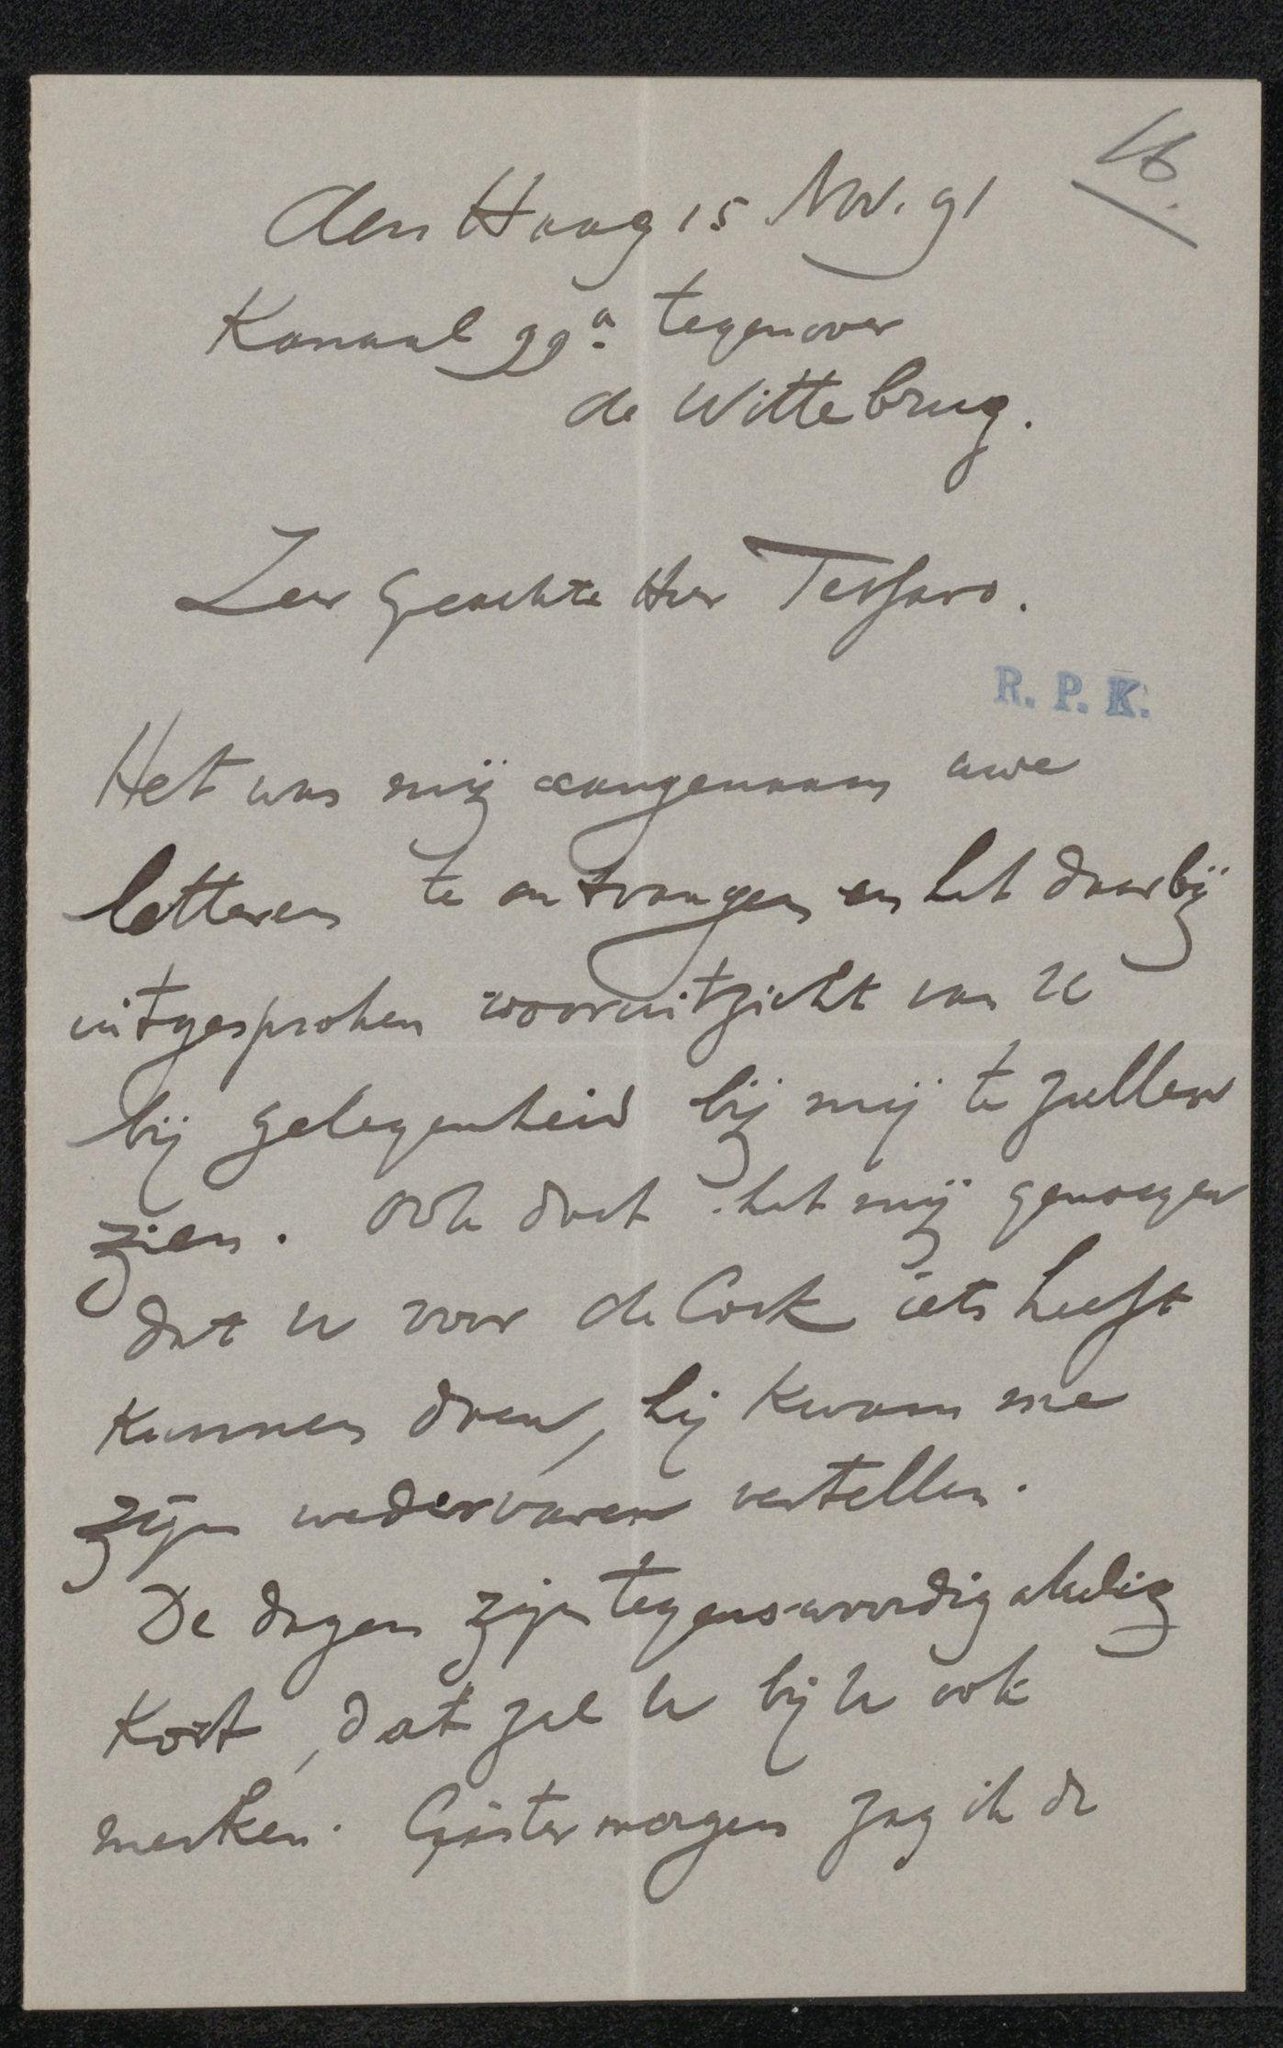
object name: letter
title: Brief aan Filippo Tessaro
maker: willem bastiaan tholen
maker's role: draughtsman, painter, print maker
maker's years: 1860-1931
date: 1891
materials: ink, paper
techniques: pen, writing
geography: the hague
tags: johannes bosboom, hendrik jan de cock, drawing, exhibition ~ art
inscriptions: collector's mark: Lugt 2233